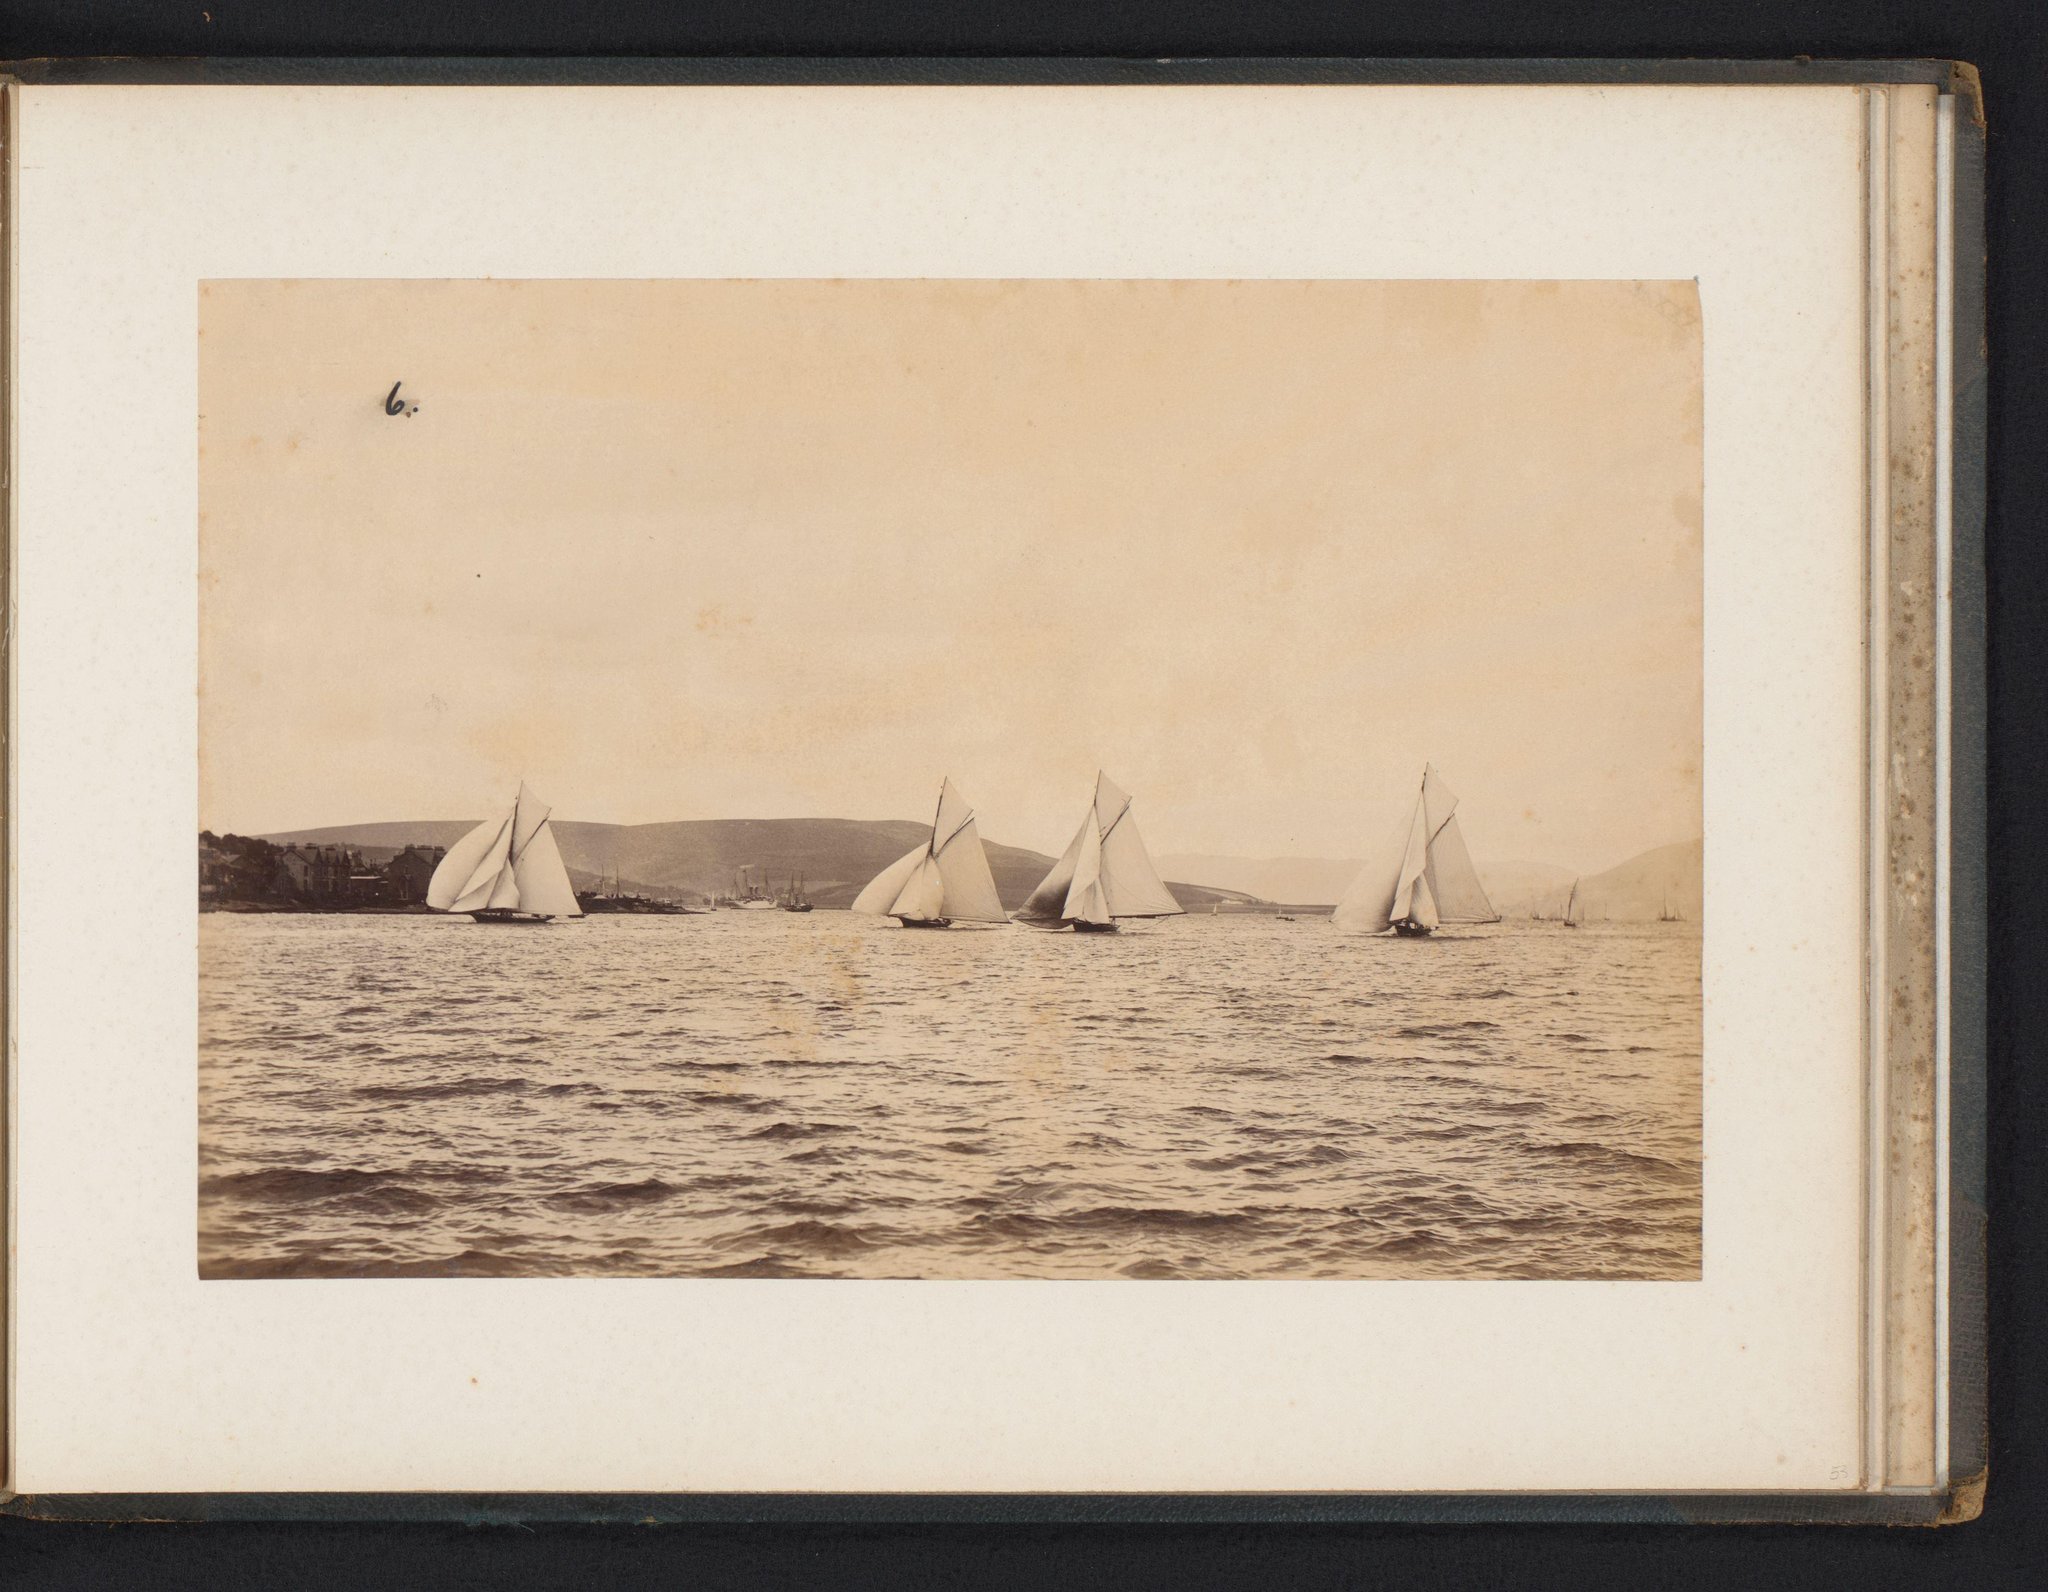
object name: album leaf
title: Verschillende zeilschepen te water met op de achtergrond een heuvelachtig landschap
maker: james adamson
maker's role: fotograaf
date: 1880-1900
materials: photographic support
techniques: albumen print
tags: sailing-ship, sailing-boat, landscapes with waters, waterscapes, seascapes (in the temperate zone), (high) hill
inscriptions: number: ‘6’, check stamp: ‘Adamson, Rothesay.H.B/ Copyright’